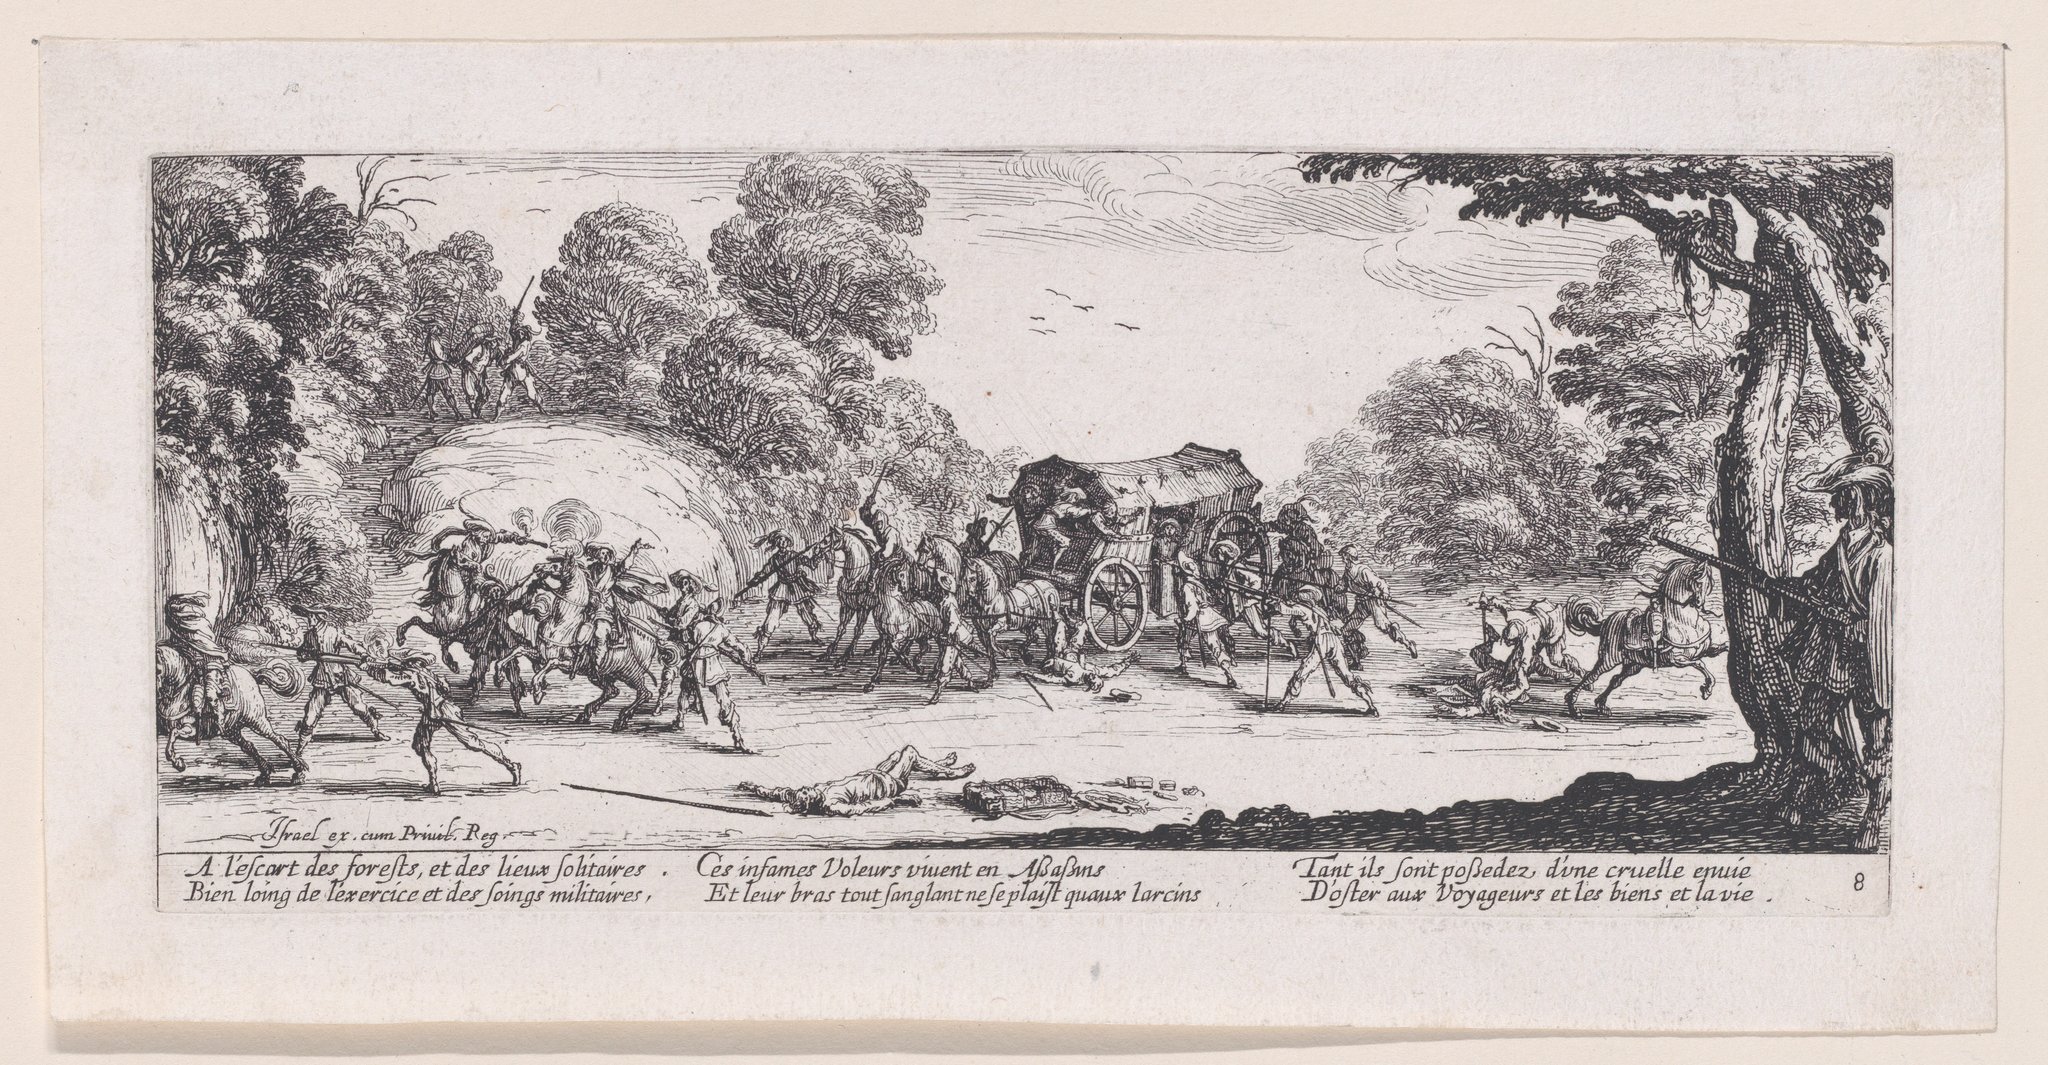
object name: print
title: L'Attaque de la Diligence (The Attack of the Stagecoach), from Les Misères et les Mal-Heures de la Guerre (The Miseries and Misfortunes of War), plate 8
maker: jacques callot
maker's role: artist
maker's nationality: french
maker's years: 1592-1635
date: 1633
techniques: etching